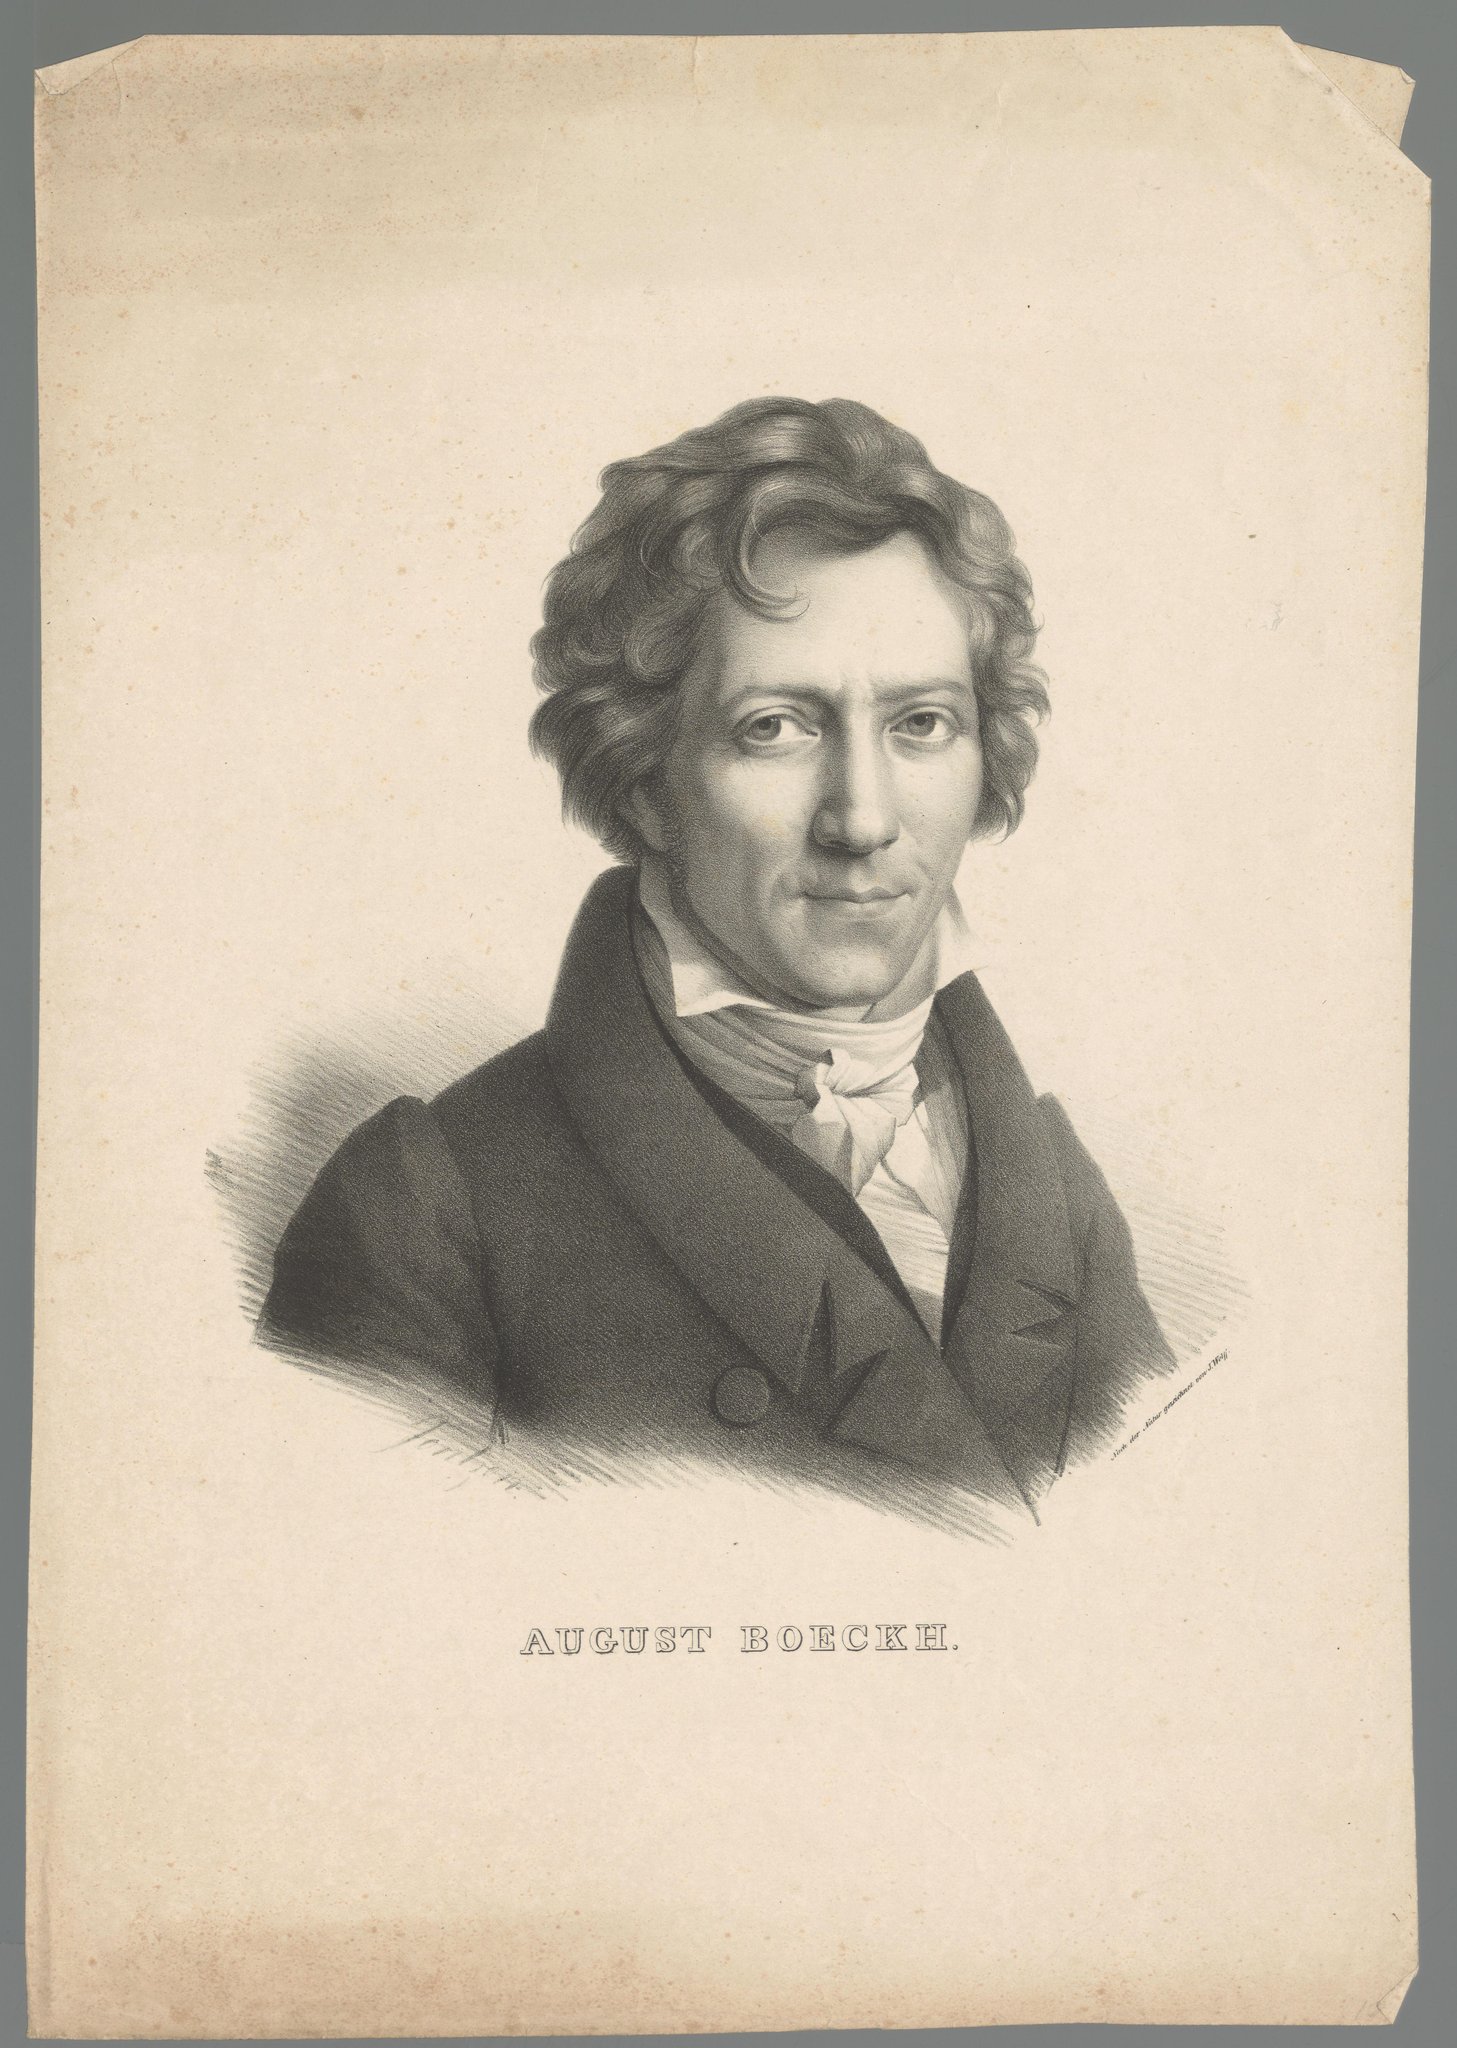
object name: print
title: August Boeckh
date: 1830-1870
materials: paper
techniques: lithograph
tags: adult man, historical persons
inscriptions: collector's mark: Lugt 2228